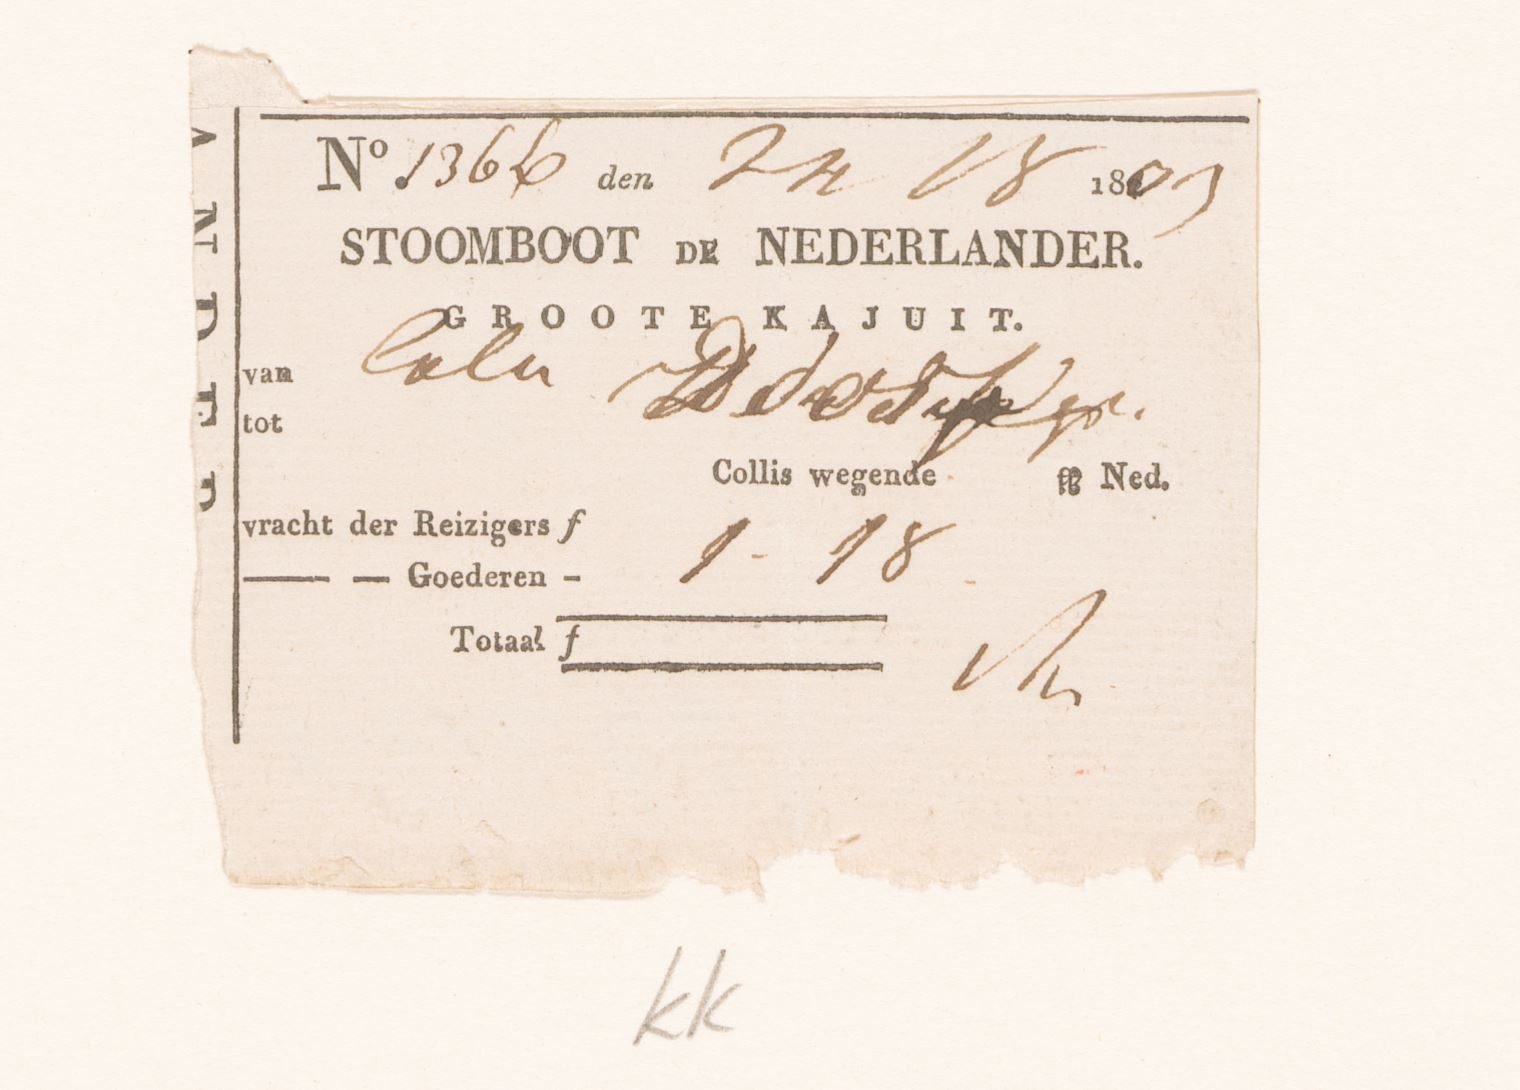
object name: travel document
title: Document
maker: Anonymous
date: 1833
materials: paper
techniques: printing, writing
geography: germany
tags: the hague, johan rudolf thorbecke, germany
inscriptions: date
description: Kaartje Stoomboot De Nederlanden uit Keulen. Gedateerd: 24 aug. 1833.